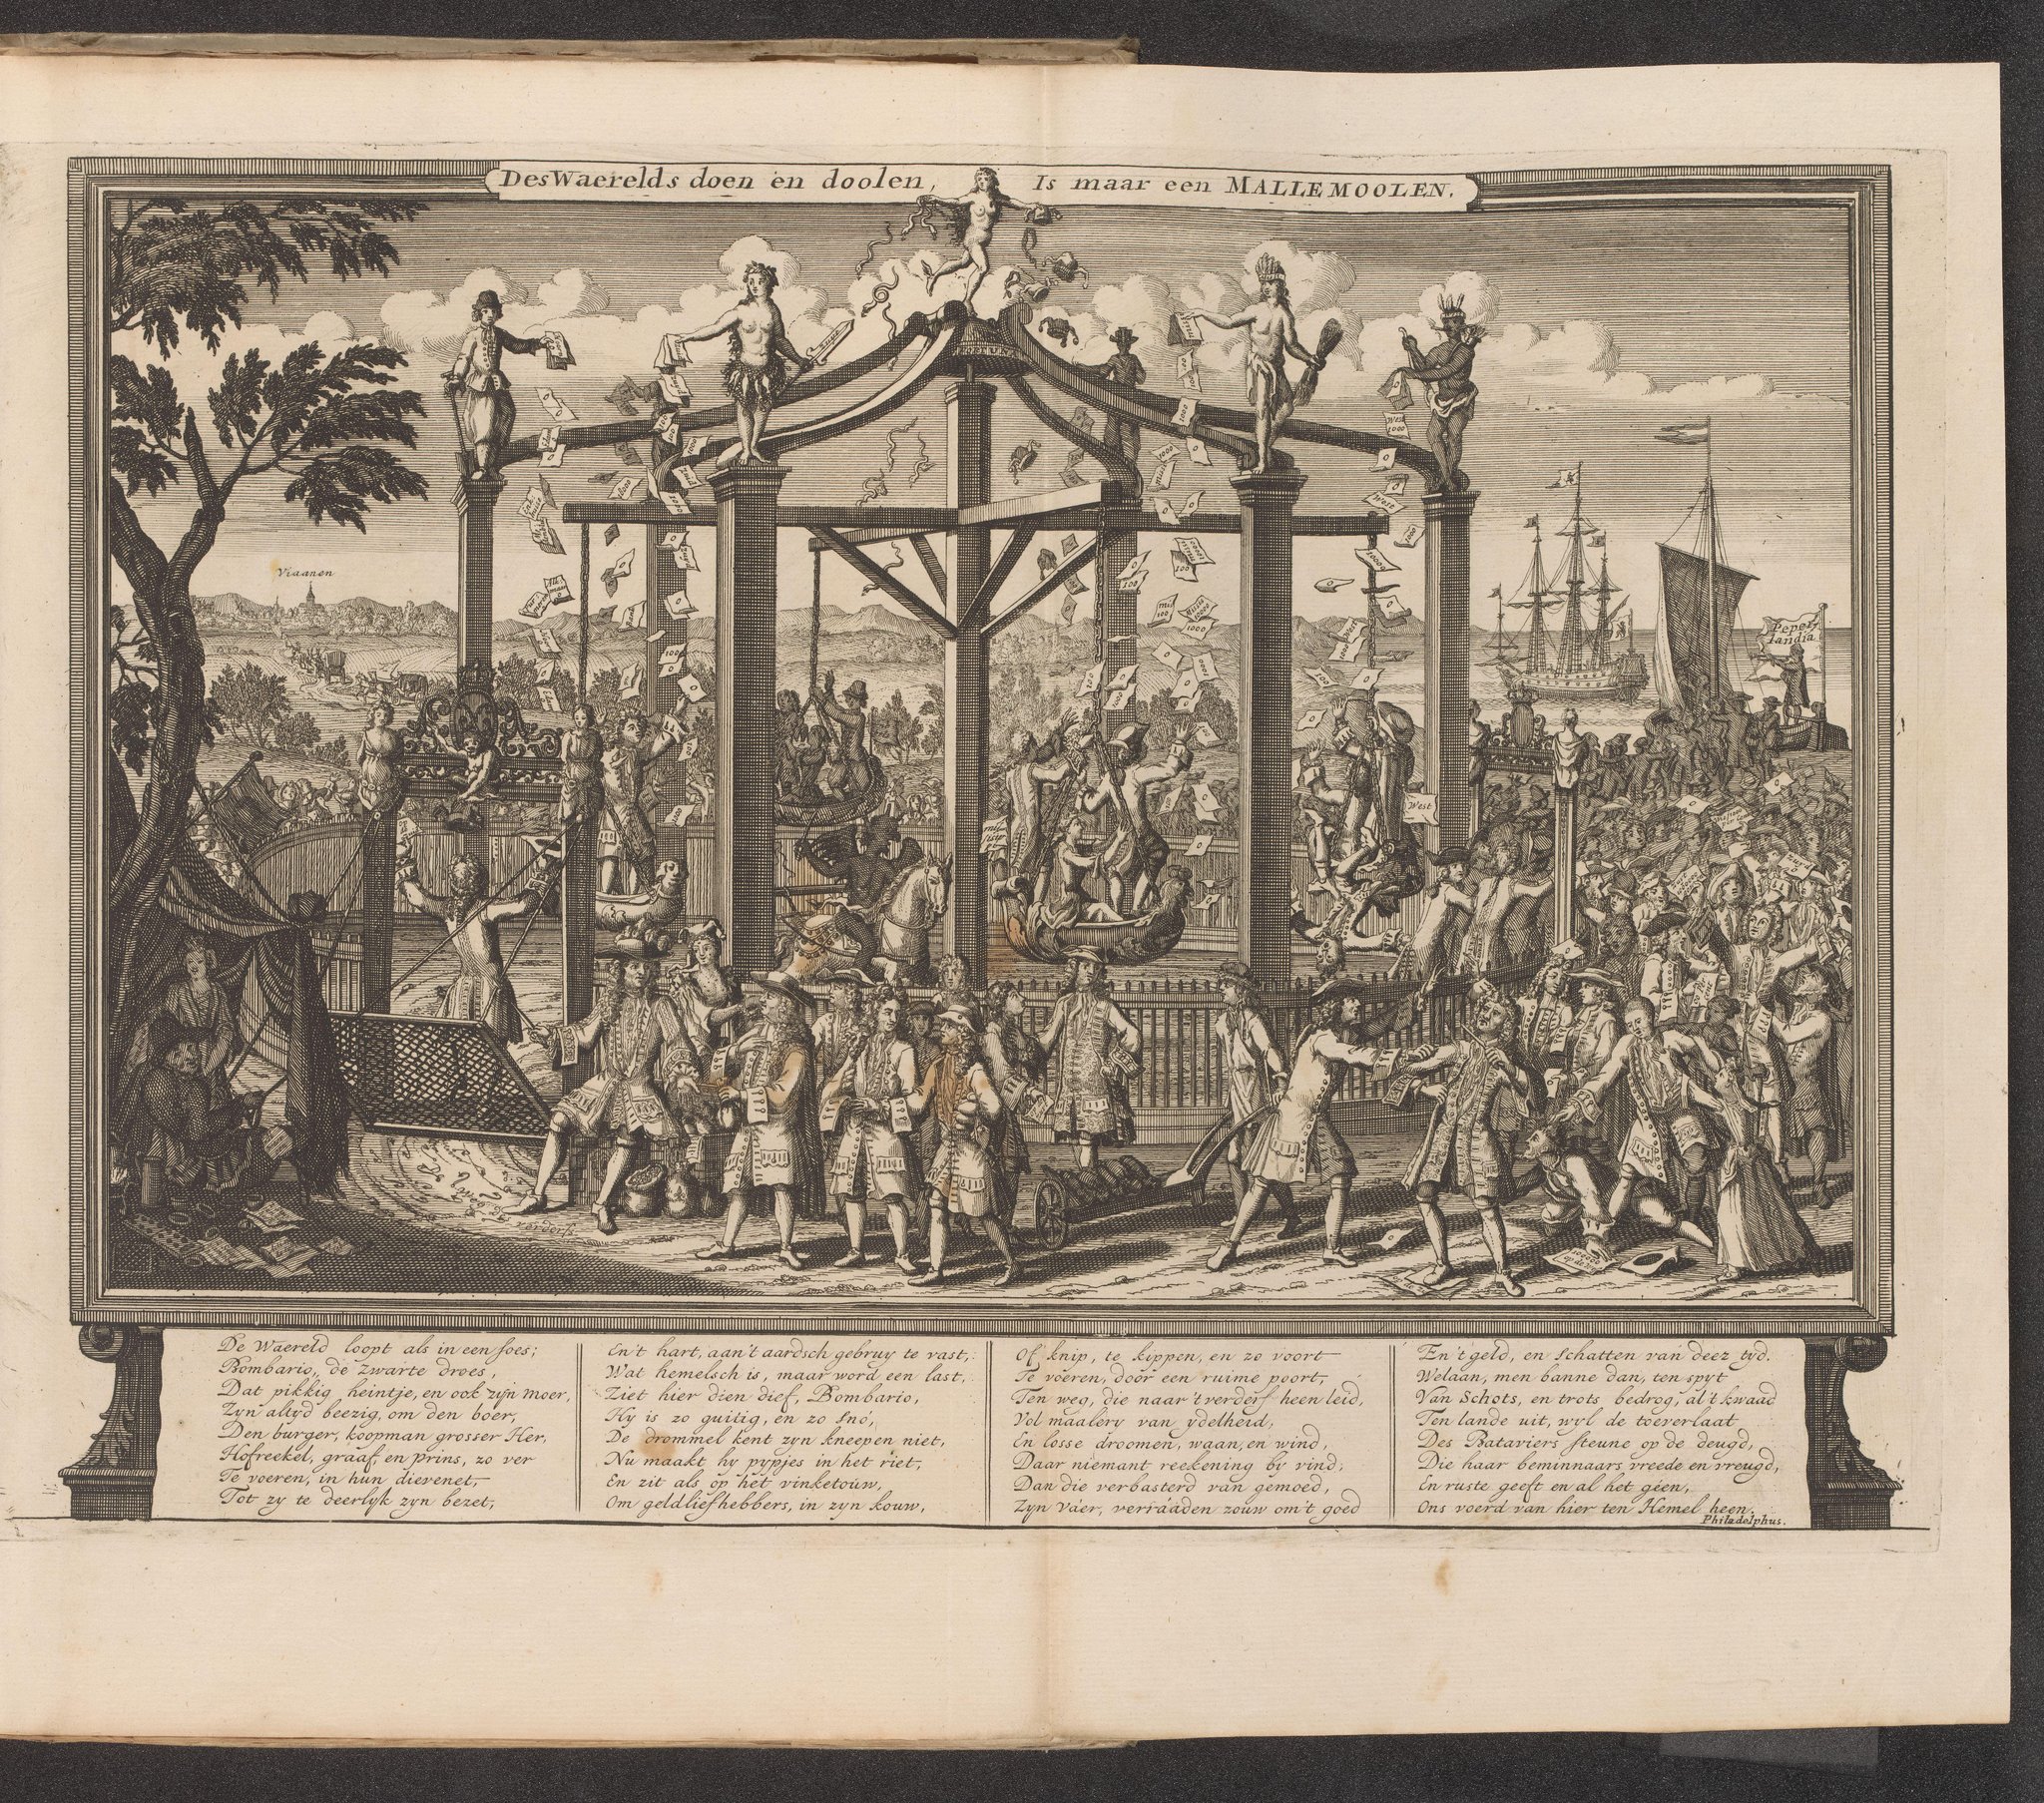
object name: cartoon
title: Mallemolen van de Wereld, 1720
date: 1720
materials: paper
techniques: etching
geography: northern netherlands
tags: merry-go-round, roundabout; chair o'plane, financial panic, indigenous peoples of the caribbean, indigenous peoples of north america, indigenous peoples of south america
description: De Mallemolen van de Wereld. Een draaimolen waarin de windhandelaren staande in de bakjes pogingen doen om aandelenbriefjes te bemachtigen die door figuren (een boer en bewoners van de Zuidzee, Mississippi en West-Indië) staande op de stijlen van de molen worden gestrooid. Op de voorgrond wachten andere heren op hun rit in de mallemolen, rechts wanhopige actionisten. Op de achtergrond links Vianen, rechts schepen op zee. Met onderschrift in vier kolommen door Philadelphus. Prent in de gebonden eerste uitgave (304 B 11) van Het Groote Tafereel der Dwaasheid met spotprenten op de Windhandel of Actiehandel van 1720.